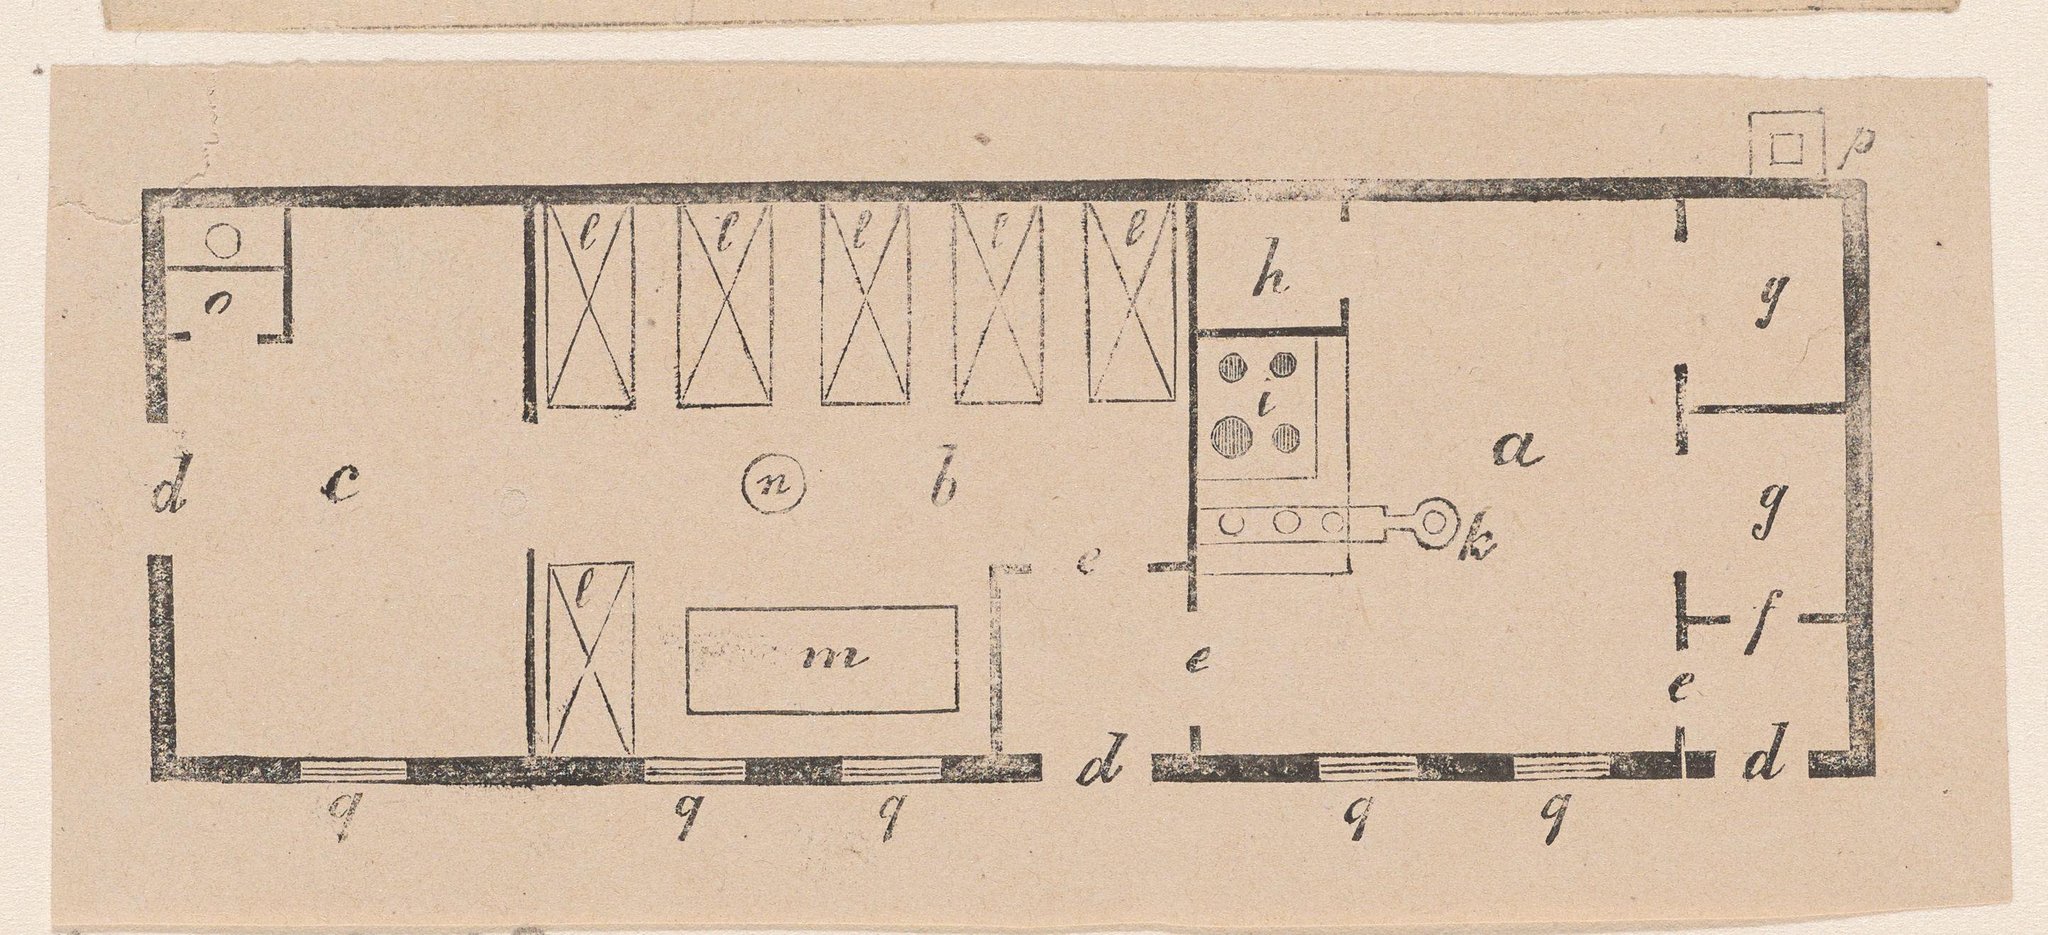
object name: print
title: Plattegrond van een bouwwerk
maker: isaac weissenbruch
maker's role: print maker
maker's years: 1826-1912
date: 1836-1912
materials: paper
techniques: engraving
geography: netherlands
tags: plan ~ architecture, civic architecture; edifices; dwellings